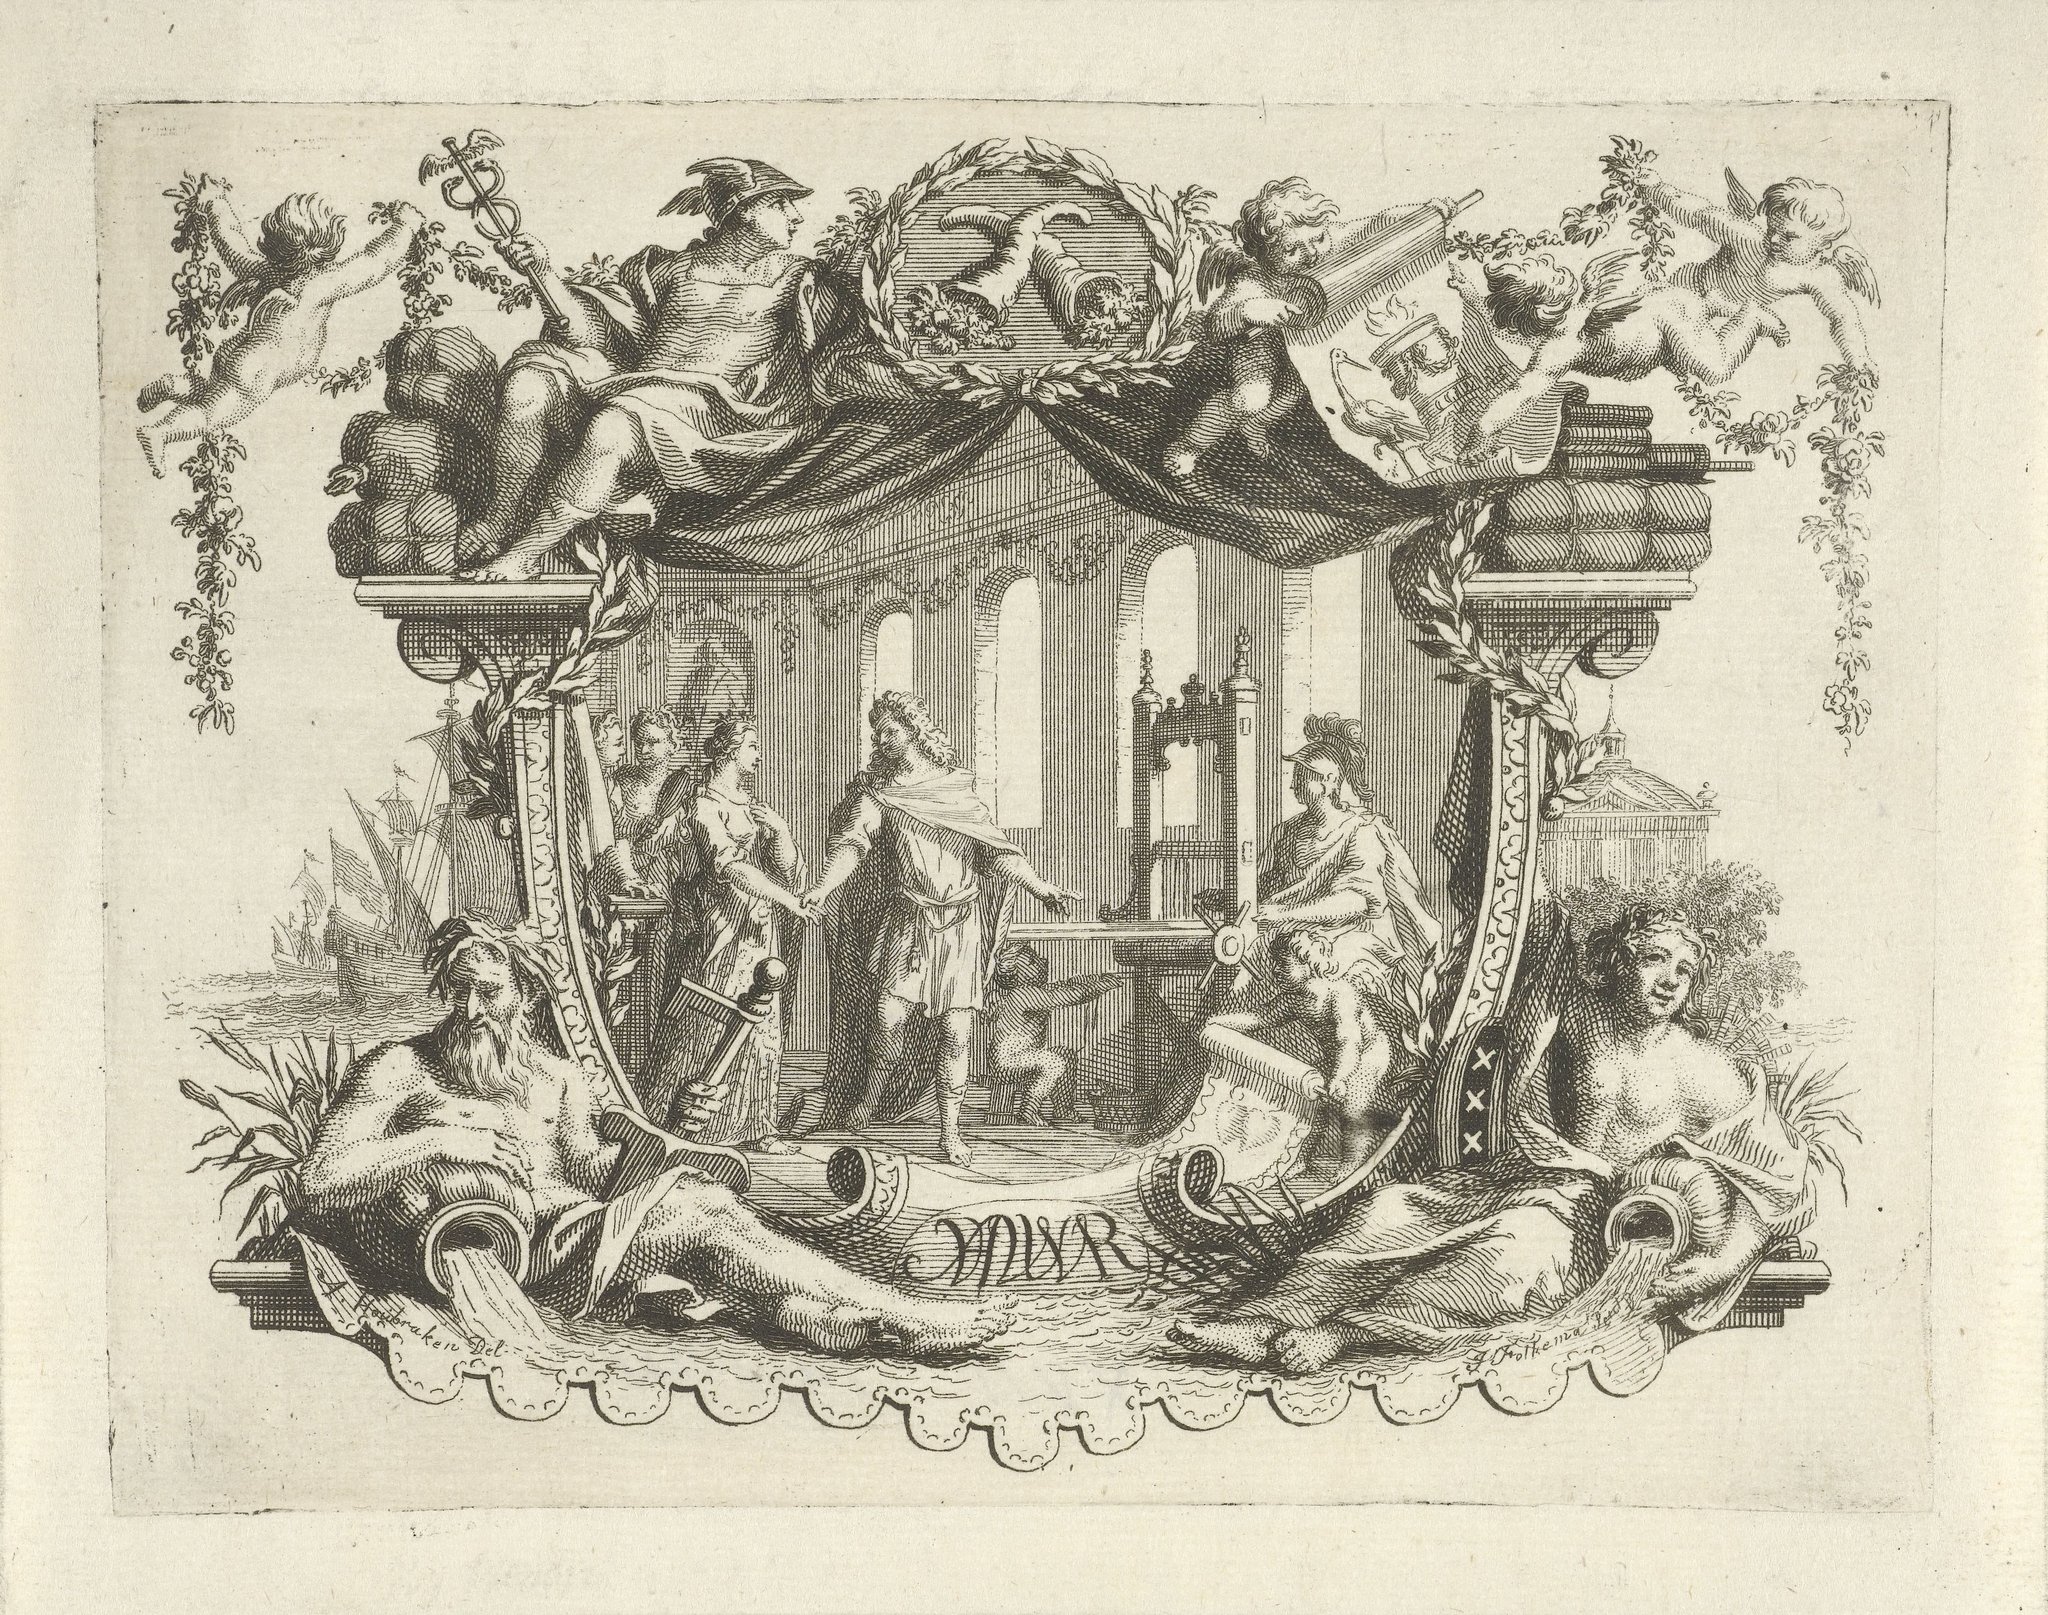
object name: print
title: Allegorische voorstelling met weefgetouw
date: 1702-1767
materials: paper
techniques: etching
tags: weaving-loom, couple of lovers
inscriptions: collector's mark: Lugt 2228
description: Een allegorische figuur zit aan het weefgetouw en wordt geholpen door een putto met een mandje garen. Naast het weefgetouw staat een liefdespaar, een putto rolt een lap stof voor hen uit waarop twee brandende harten staan afgebeeld. De scène is omgeven door een rijk versierde lijst, getooid met twee gekruiste hoornen des overvloeds en geflankeerd door Mercurius en een putto die een offerzuil en een pelikaan op een stuk stof toont. Voor de lijst liggen twee riviergoden, rechts het wapen van Amsterdam.